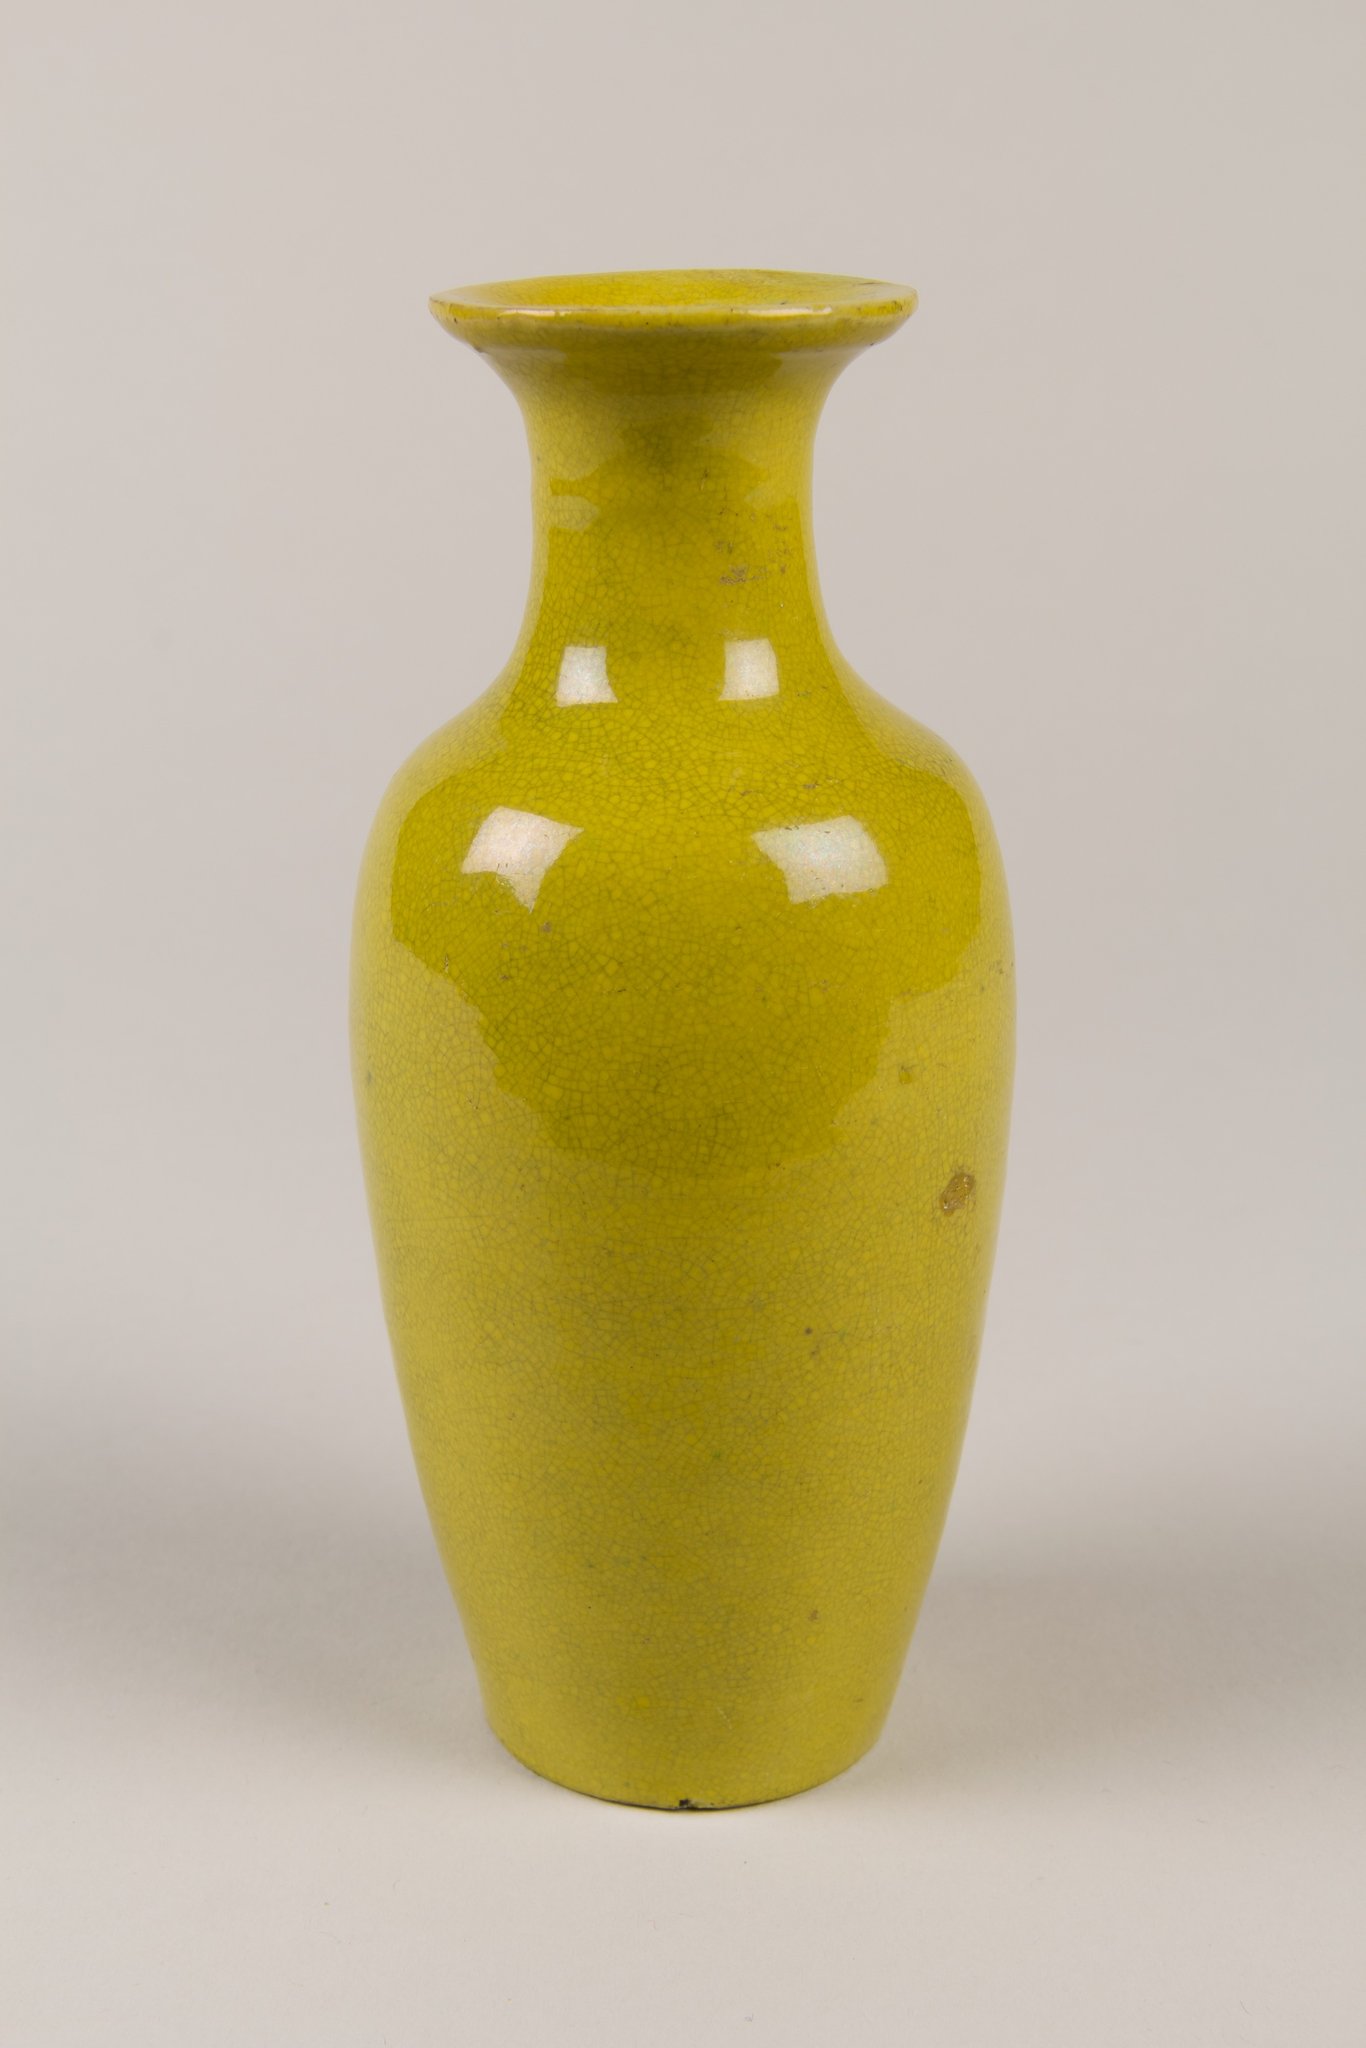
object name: vase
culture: chinese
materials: glaze, porcelain